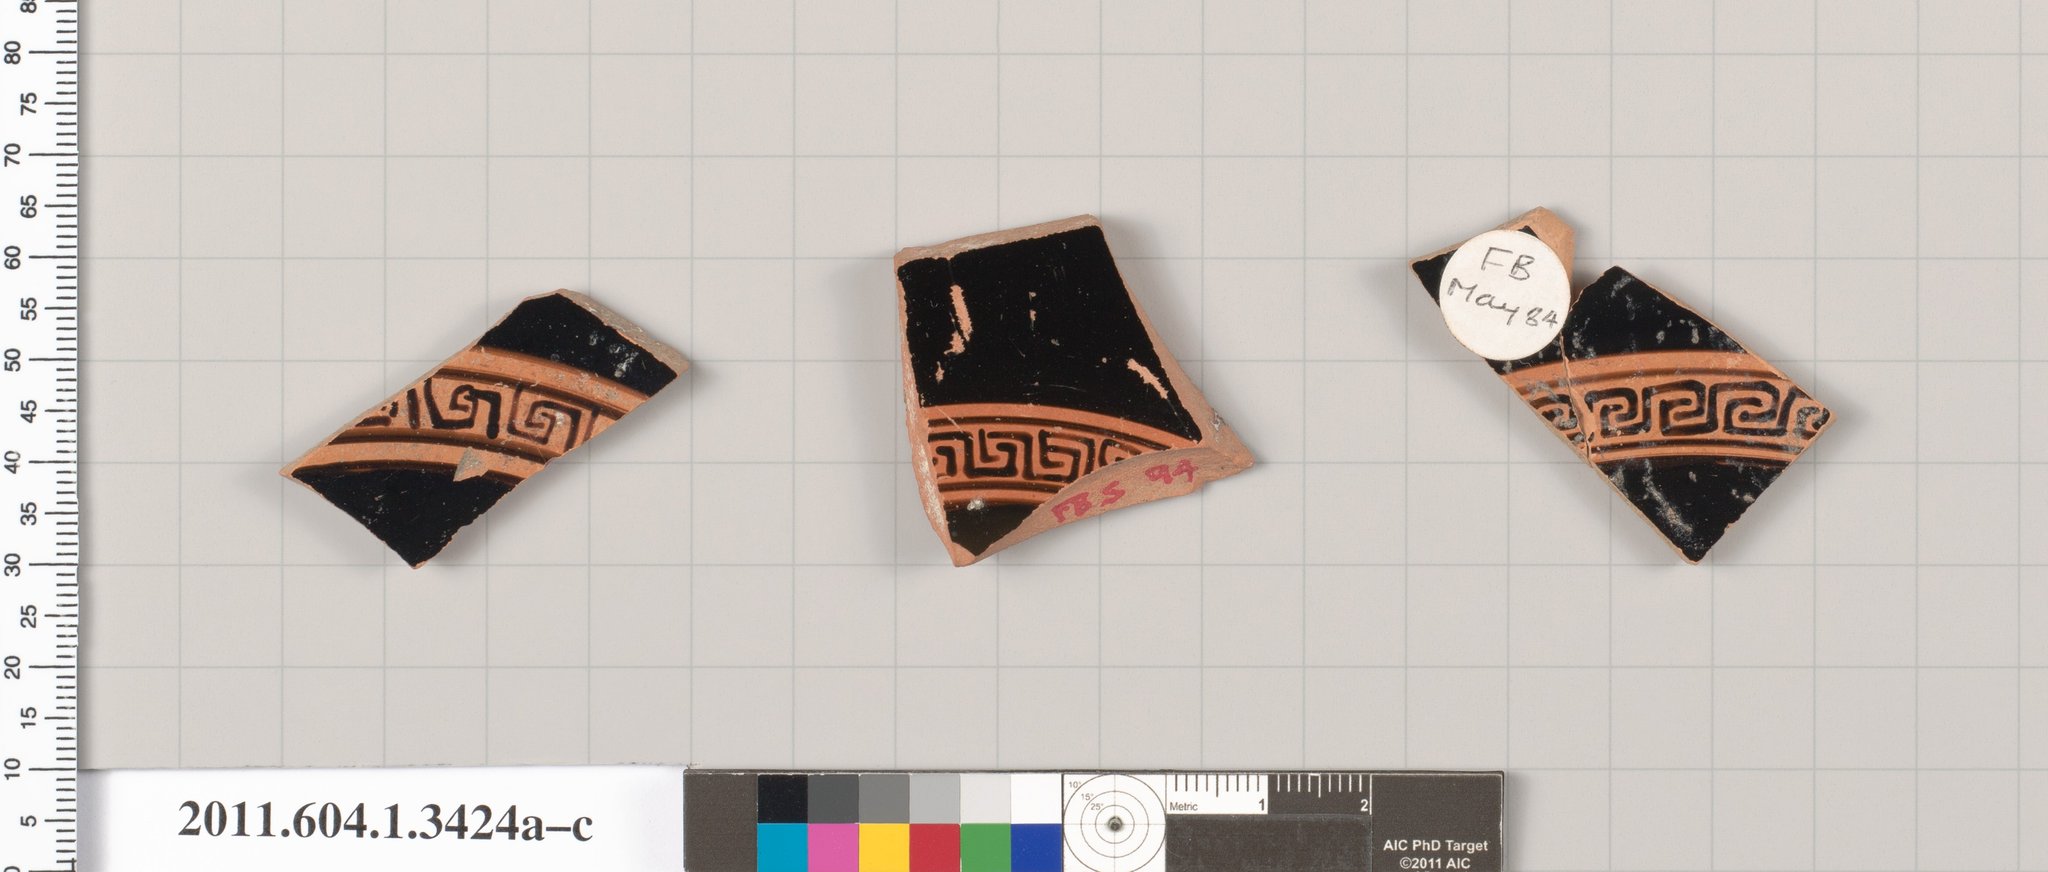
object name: kylix fragment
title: Terracotta fragments of kylikes (drinking cups)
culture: greek, attic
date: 500-470 BCE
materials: terracotta